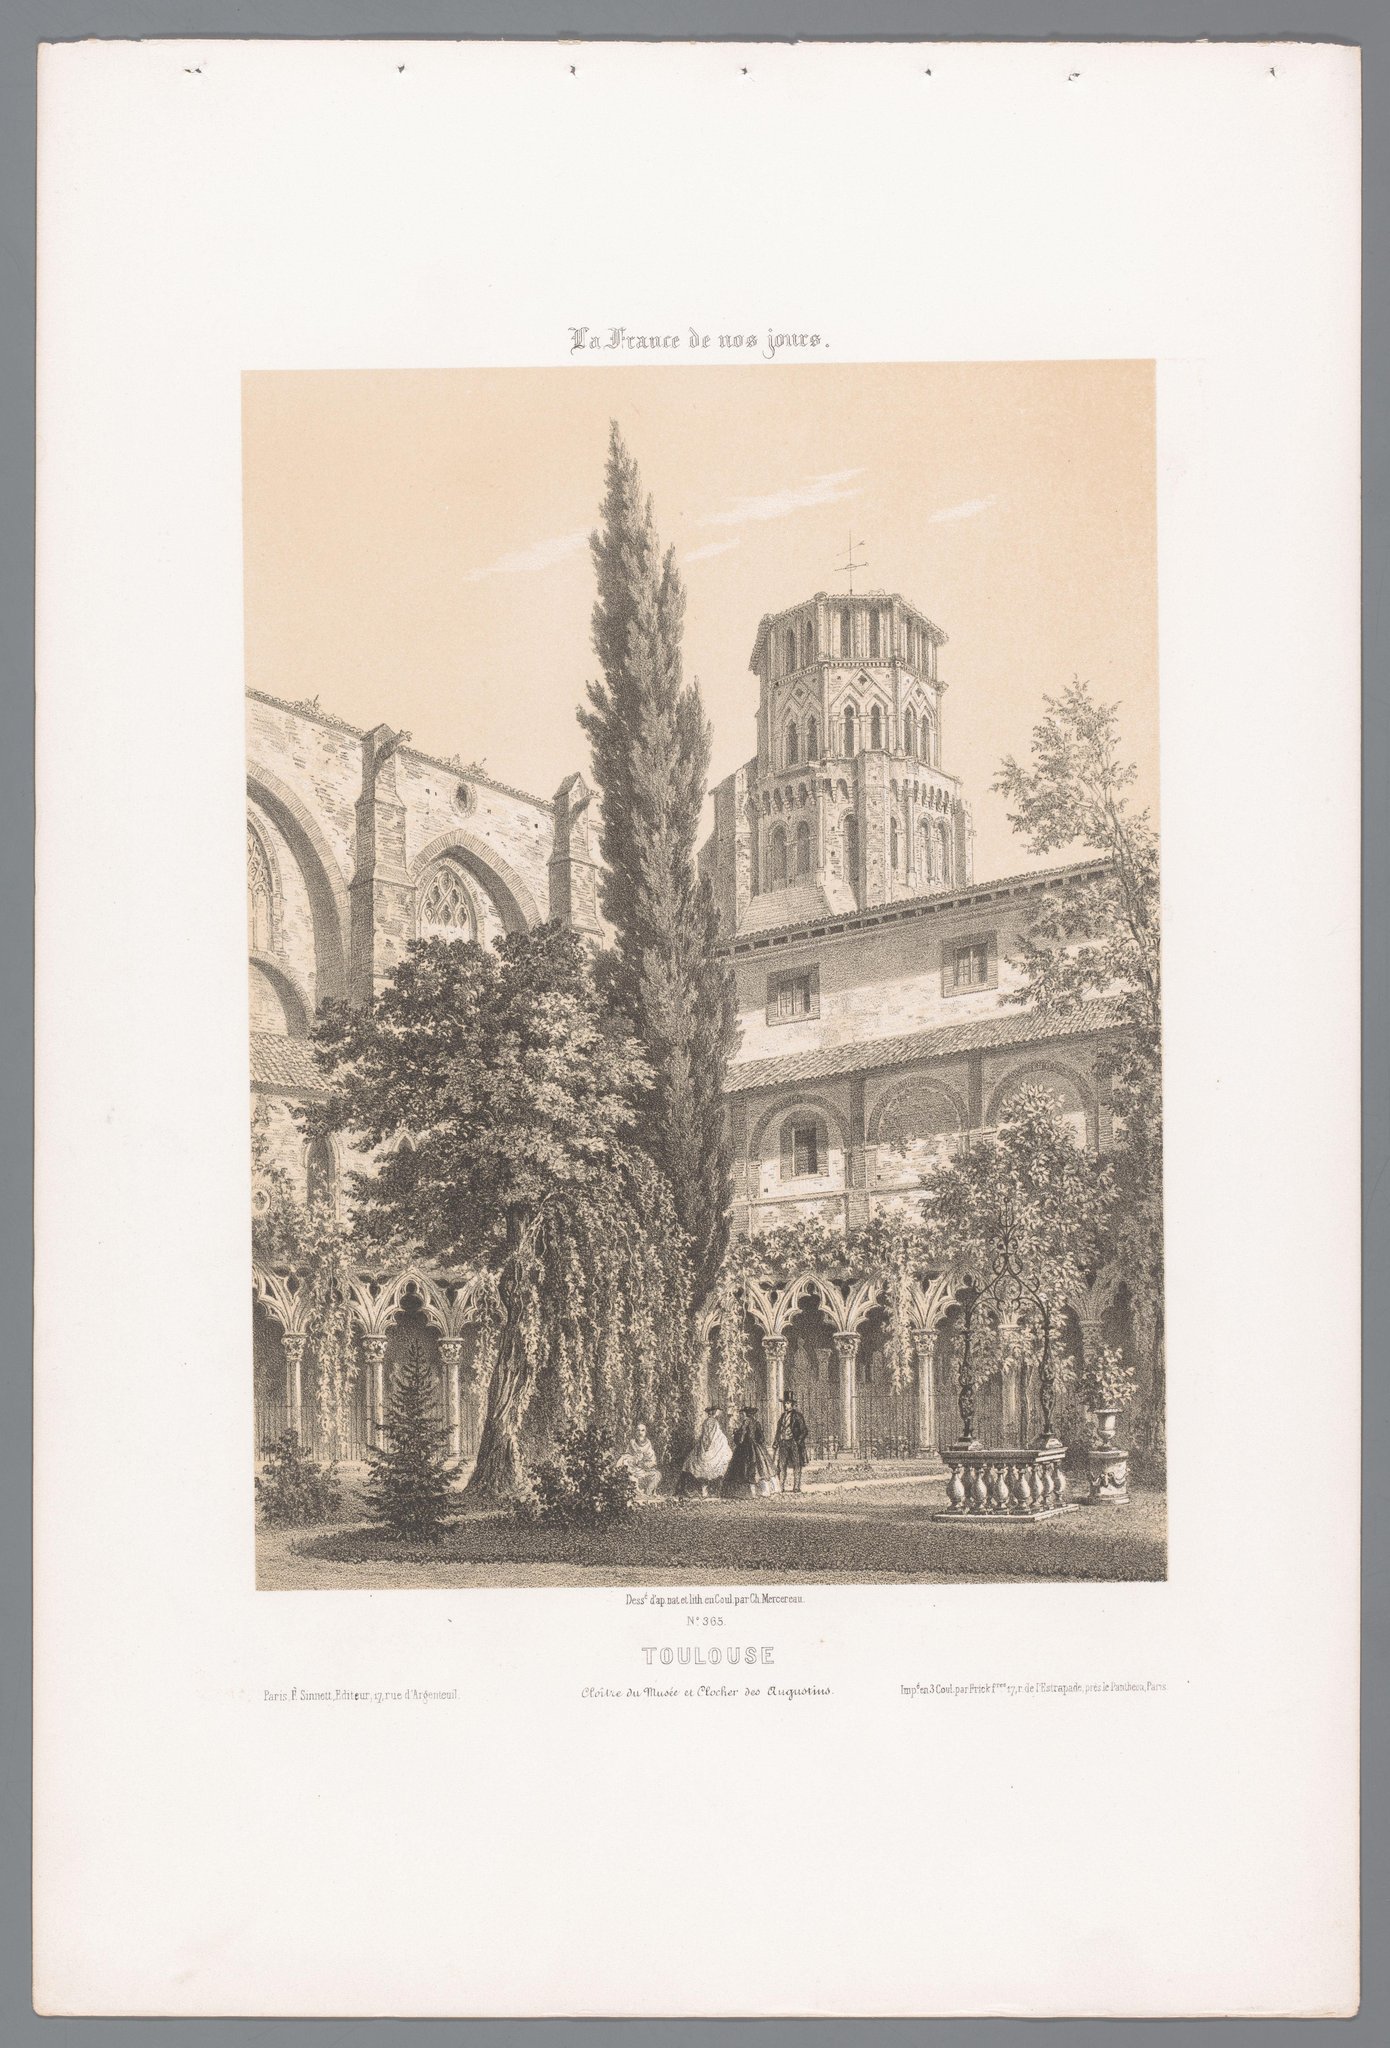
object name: print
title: Hedendaags Frankrijk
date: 1856-1874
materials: paper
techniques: tone lithography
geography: paris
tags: city-view, and landscape with man-made constructions, church (exterior), cloisters ~ monastery, permanent exhibition, museum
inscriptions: collector's mark: Lugt 2228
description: Gevestigd in het voormalige Augustijnerklooster.